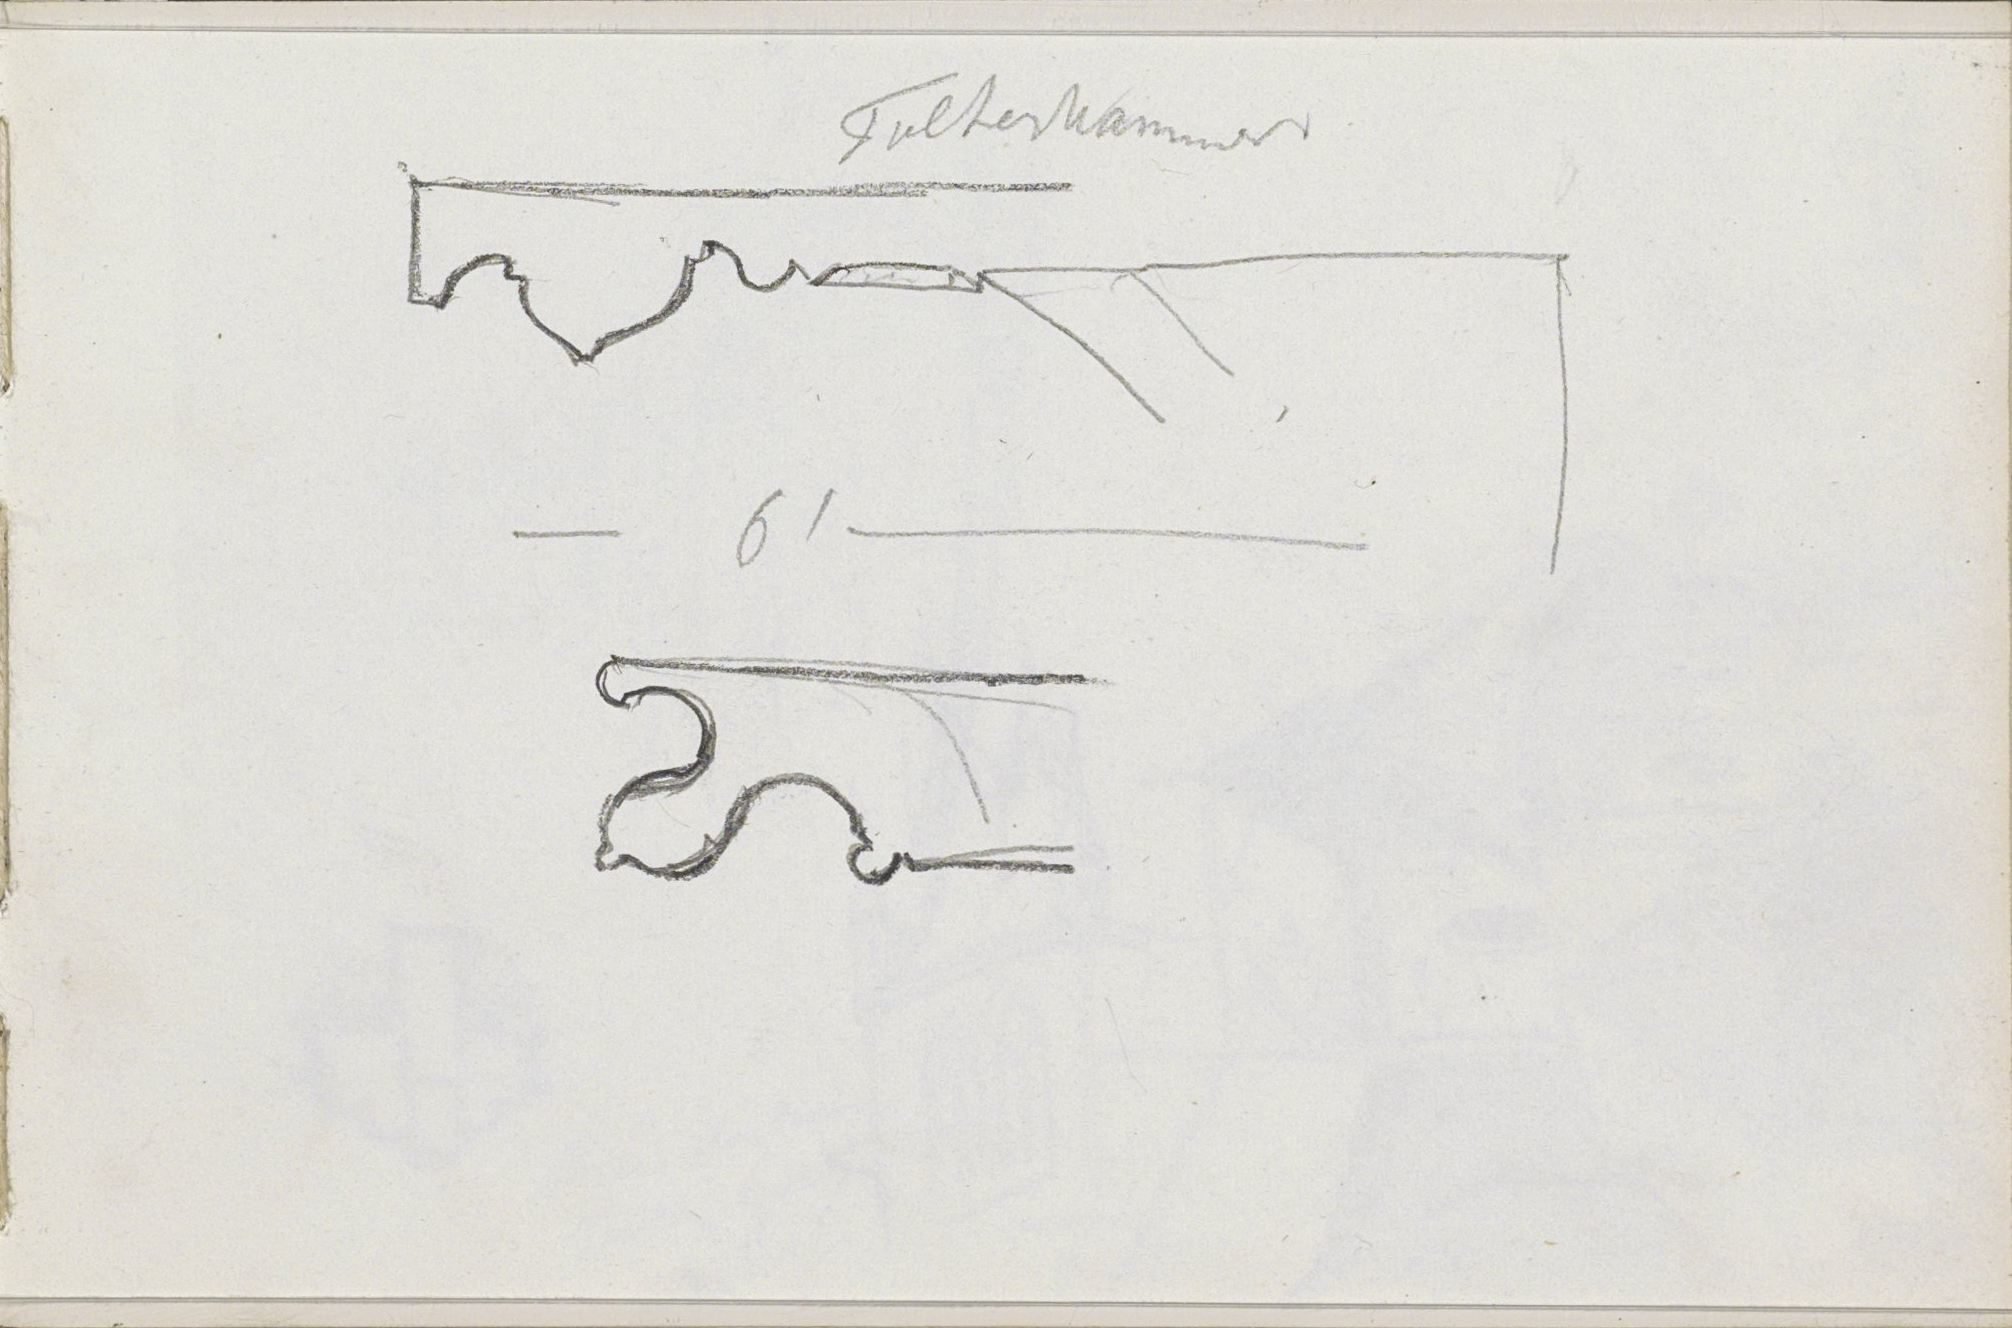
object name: sketchbook leaf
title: Architectuurstudies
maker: isaac gosschalk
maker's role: draughtsman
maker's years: 1838-1907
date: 1860-1861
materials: paper, pencil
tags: architectural detail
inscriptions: annotation: ‘Fulterkamm[...]/ 61’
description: Mogelijk ornamentele balken. Blad 24 recto uit een schetsboek met 29 bladen.